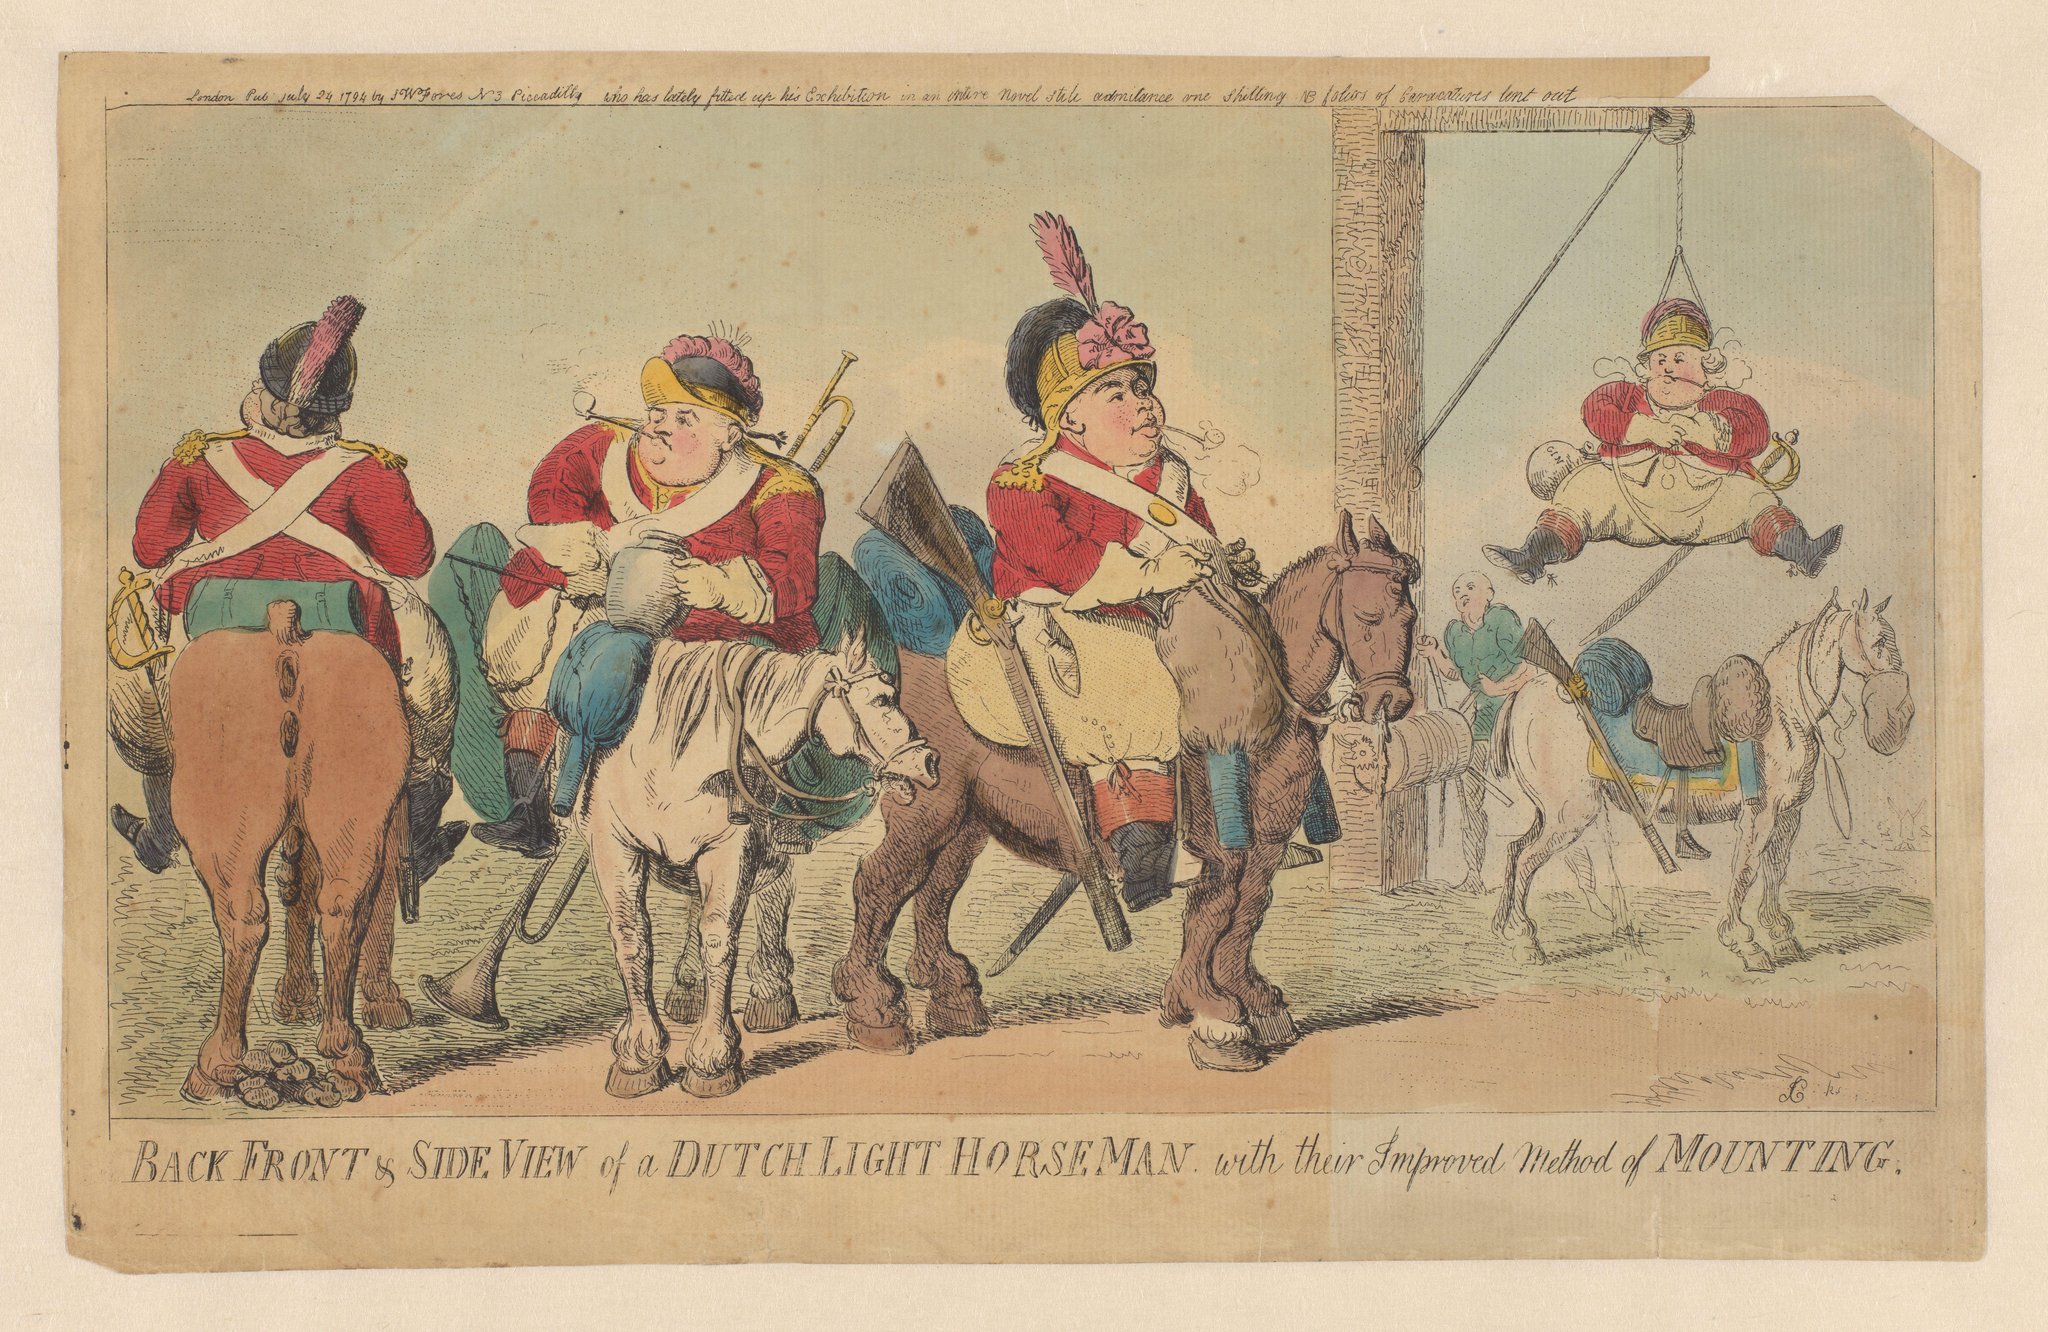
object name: cartoon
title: Back front & side view of a Dutch light horse-man, with their improved method of mounting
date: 1794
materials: paper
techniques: etching, hand coloring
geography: london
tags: fat (human type), saddling and bridling, preparation for battle (+ calvary, horsemen), horse, dutch republic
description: A characteristic feature of how the Dutch are portrayed in English satirical prints is their great girth. A love of smoking and gin were also deemed typically Dutch. Here, Cruikshank ridicules the physique of the Dutch soldier. To mount a horse, these ‘light’ cavalrymen need an improvised pulley. The French had nothing to fear from these troops.